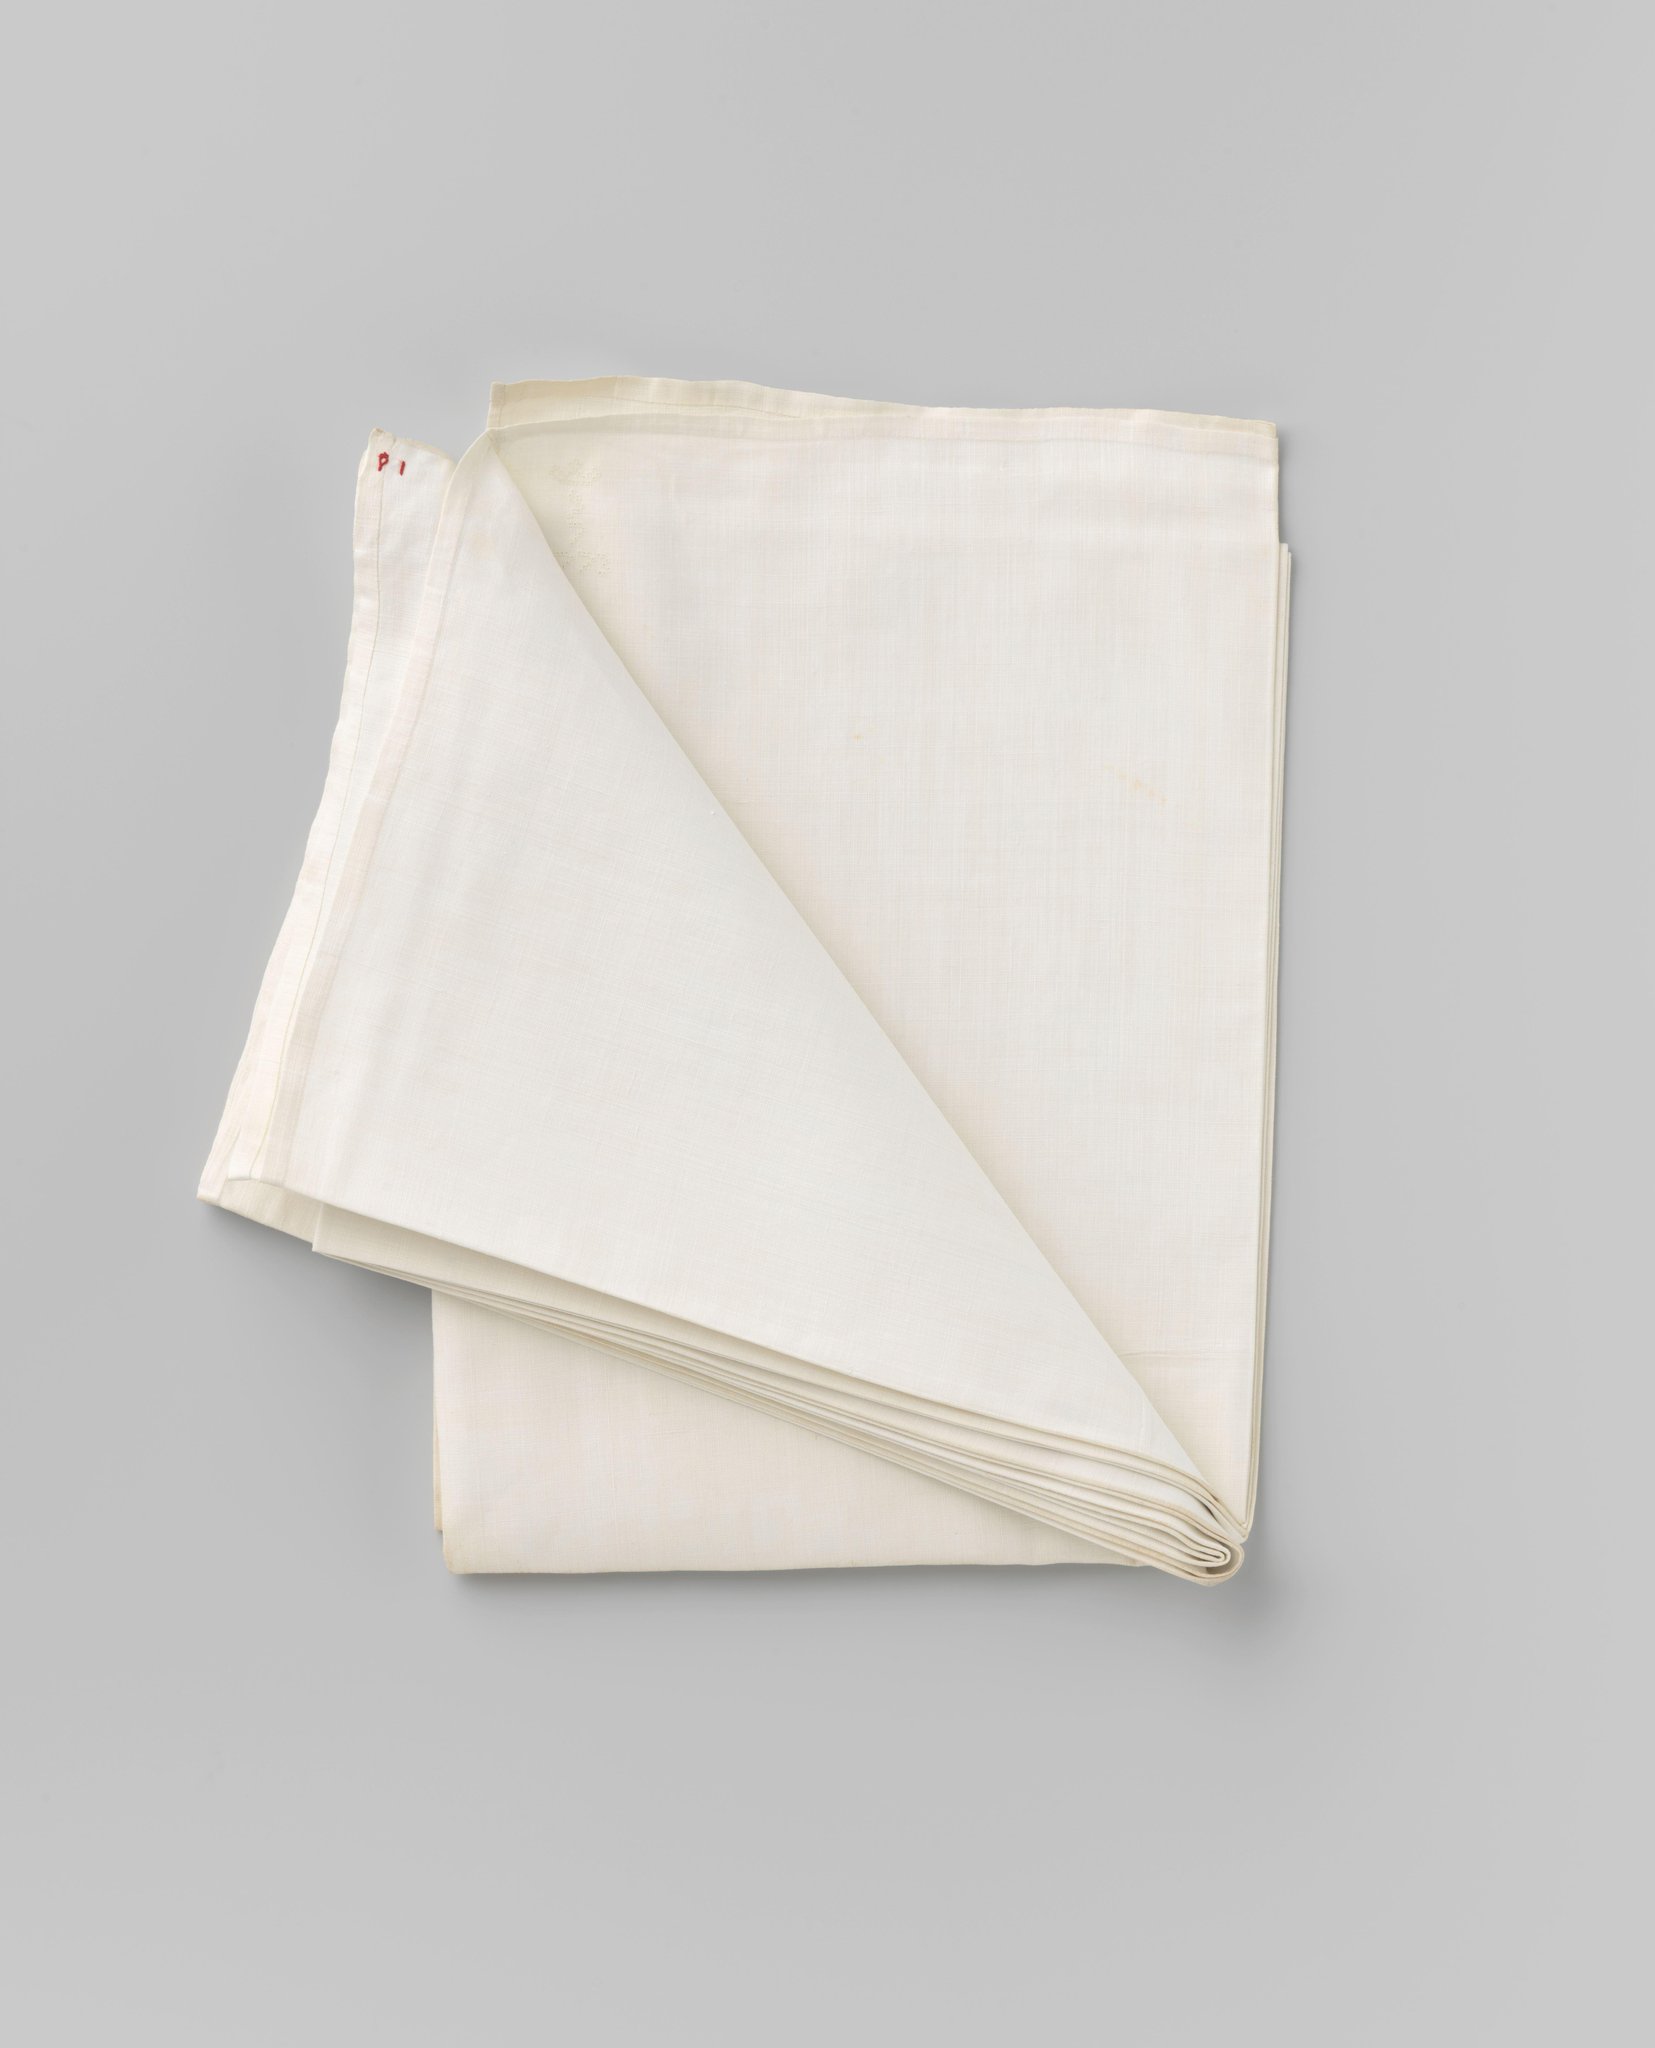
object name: beddenlaken, laken object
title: Laken. Merk: kroon G7 en jaartal 1773.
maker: Anonymous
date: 1773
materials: linen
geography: northern netherlands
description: Laken van wit linnen, merk kroon G7 en jaartal 1773